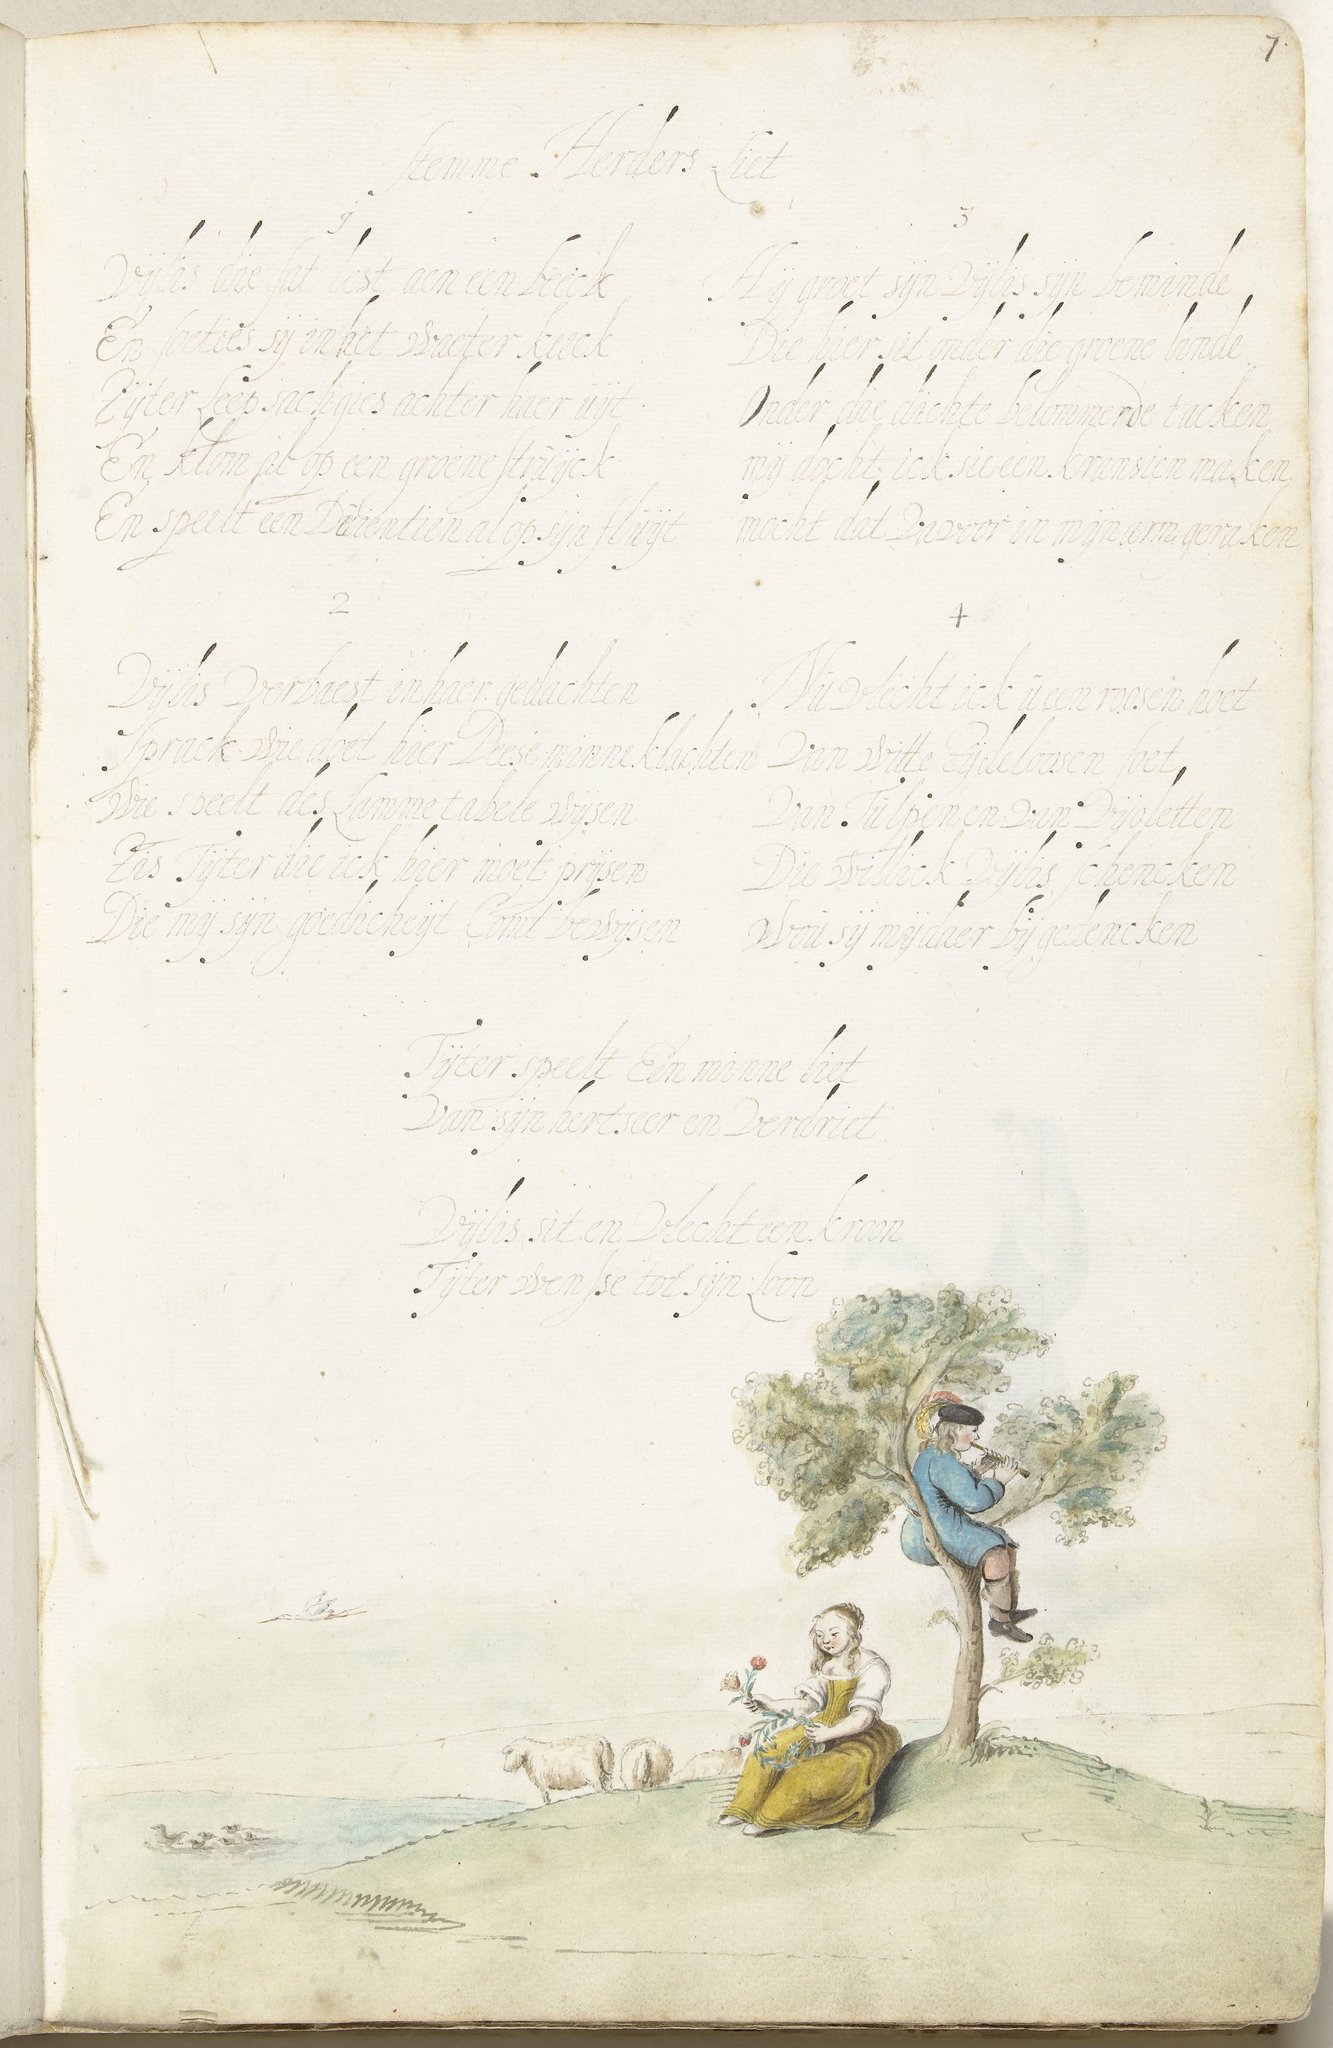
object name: calligraphy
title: Herderspaar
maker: gesina ter borch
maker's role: draughtsman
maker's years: 1633-1690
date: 1652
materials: ink, paper, watercolor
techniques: brush, calligraphy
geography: zwolle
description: Herderspaar onder pastoraal gedicht op de melodie van Herders Liet. Gesina heeft boven de illustratie in haar eigen woorden twee coupletten toegevoegd.